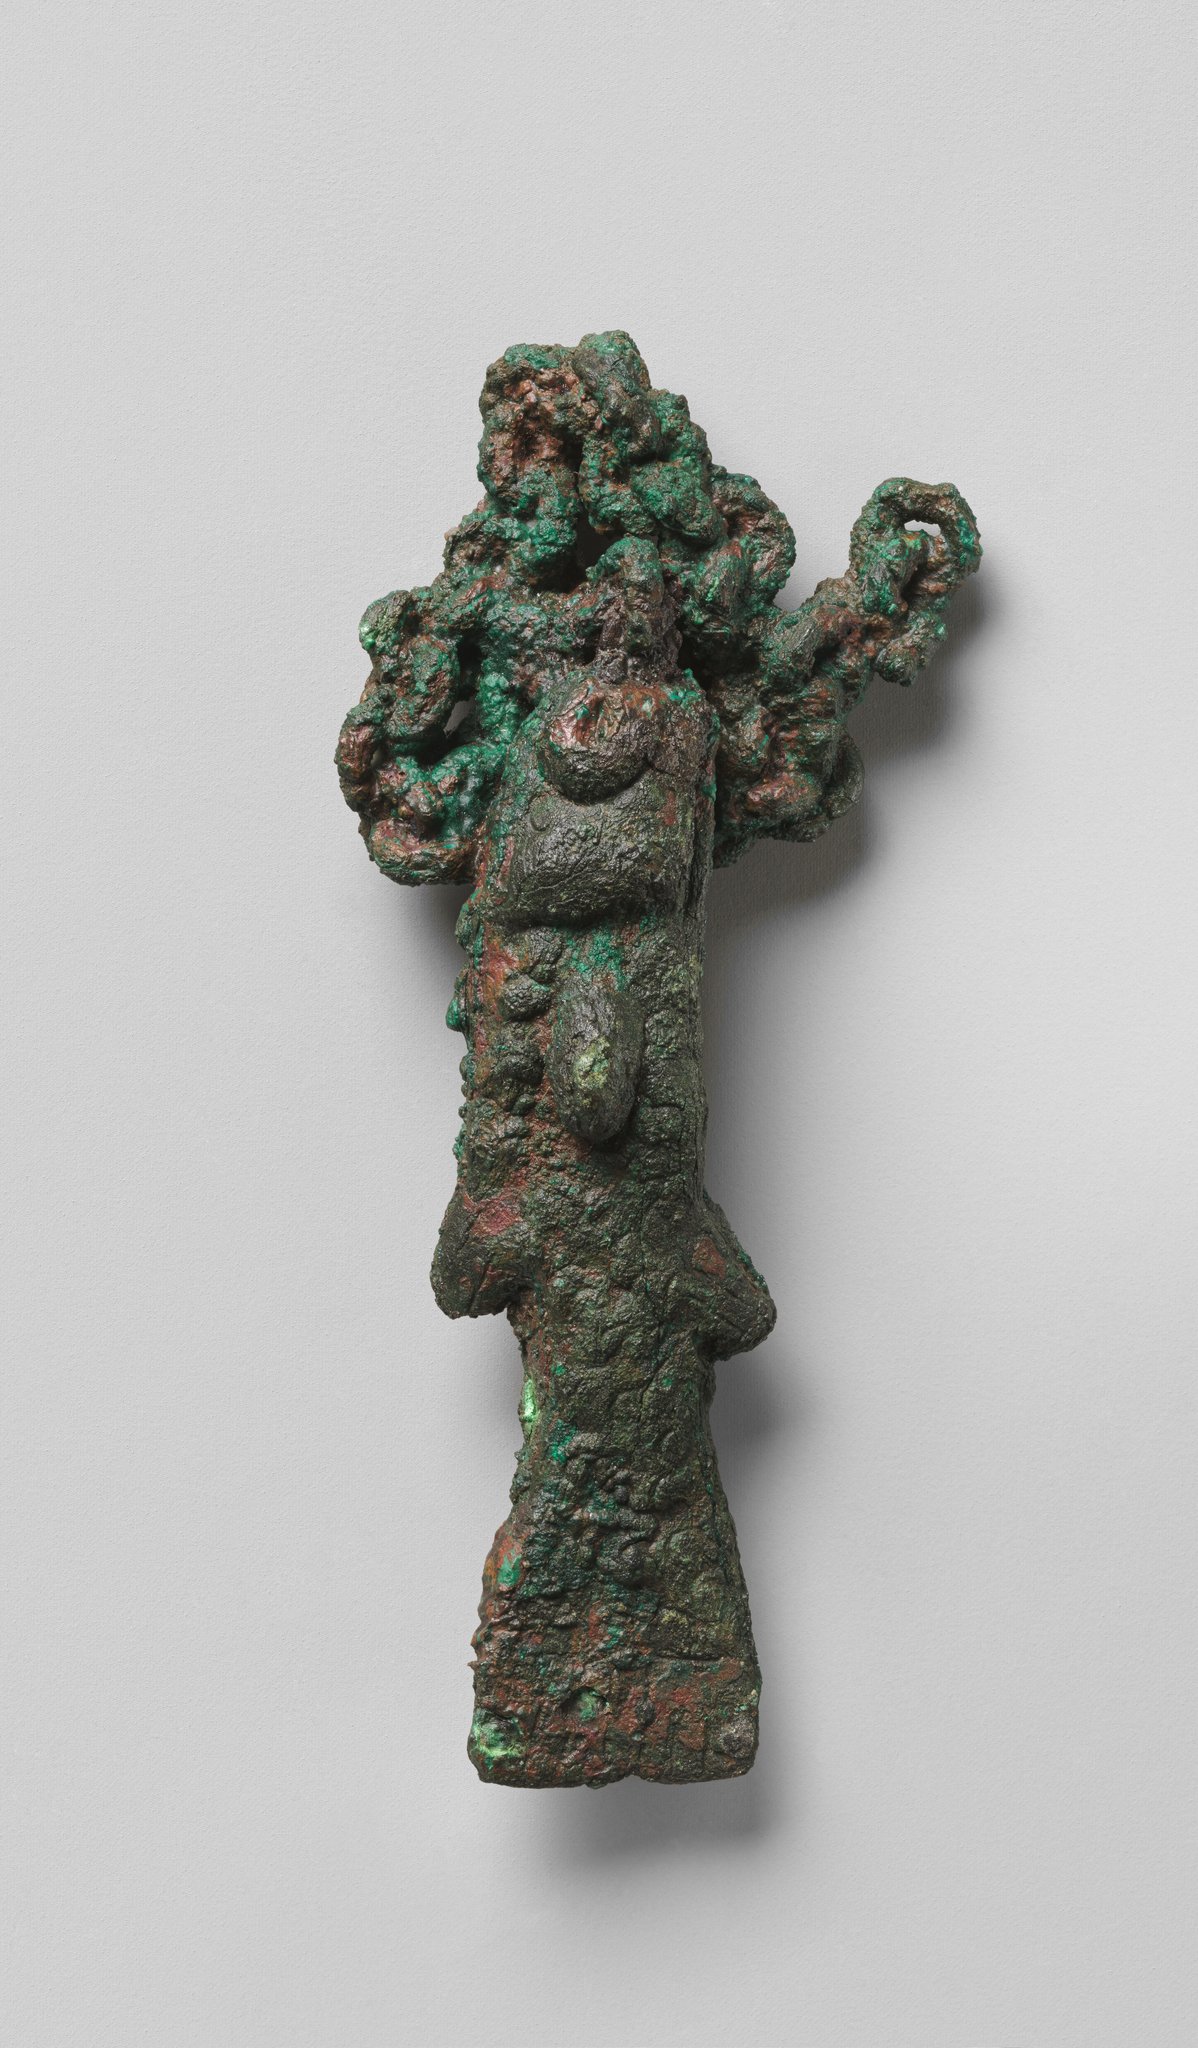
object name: necklace, bead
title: Fish amulet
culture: iranian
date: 900-801 BCE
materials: bronze, copper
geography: iran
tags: fish